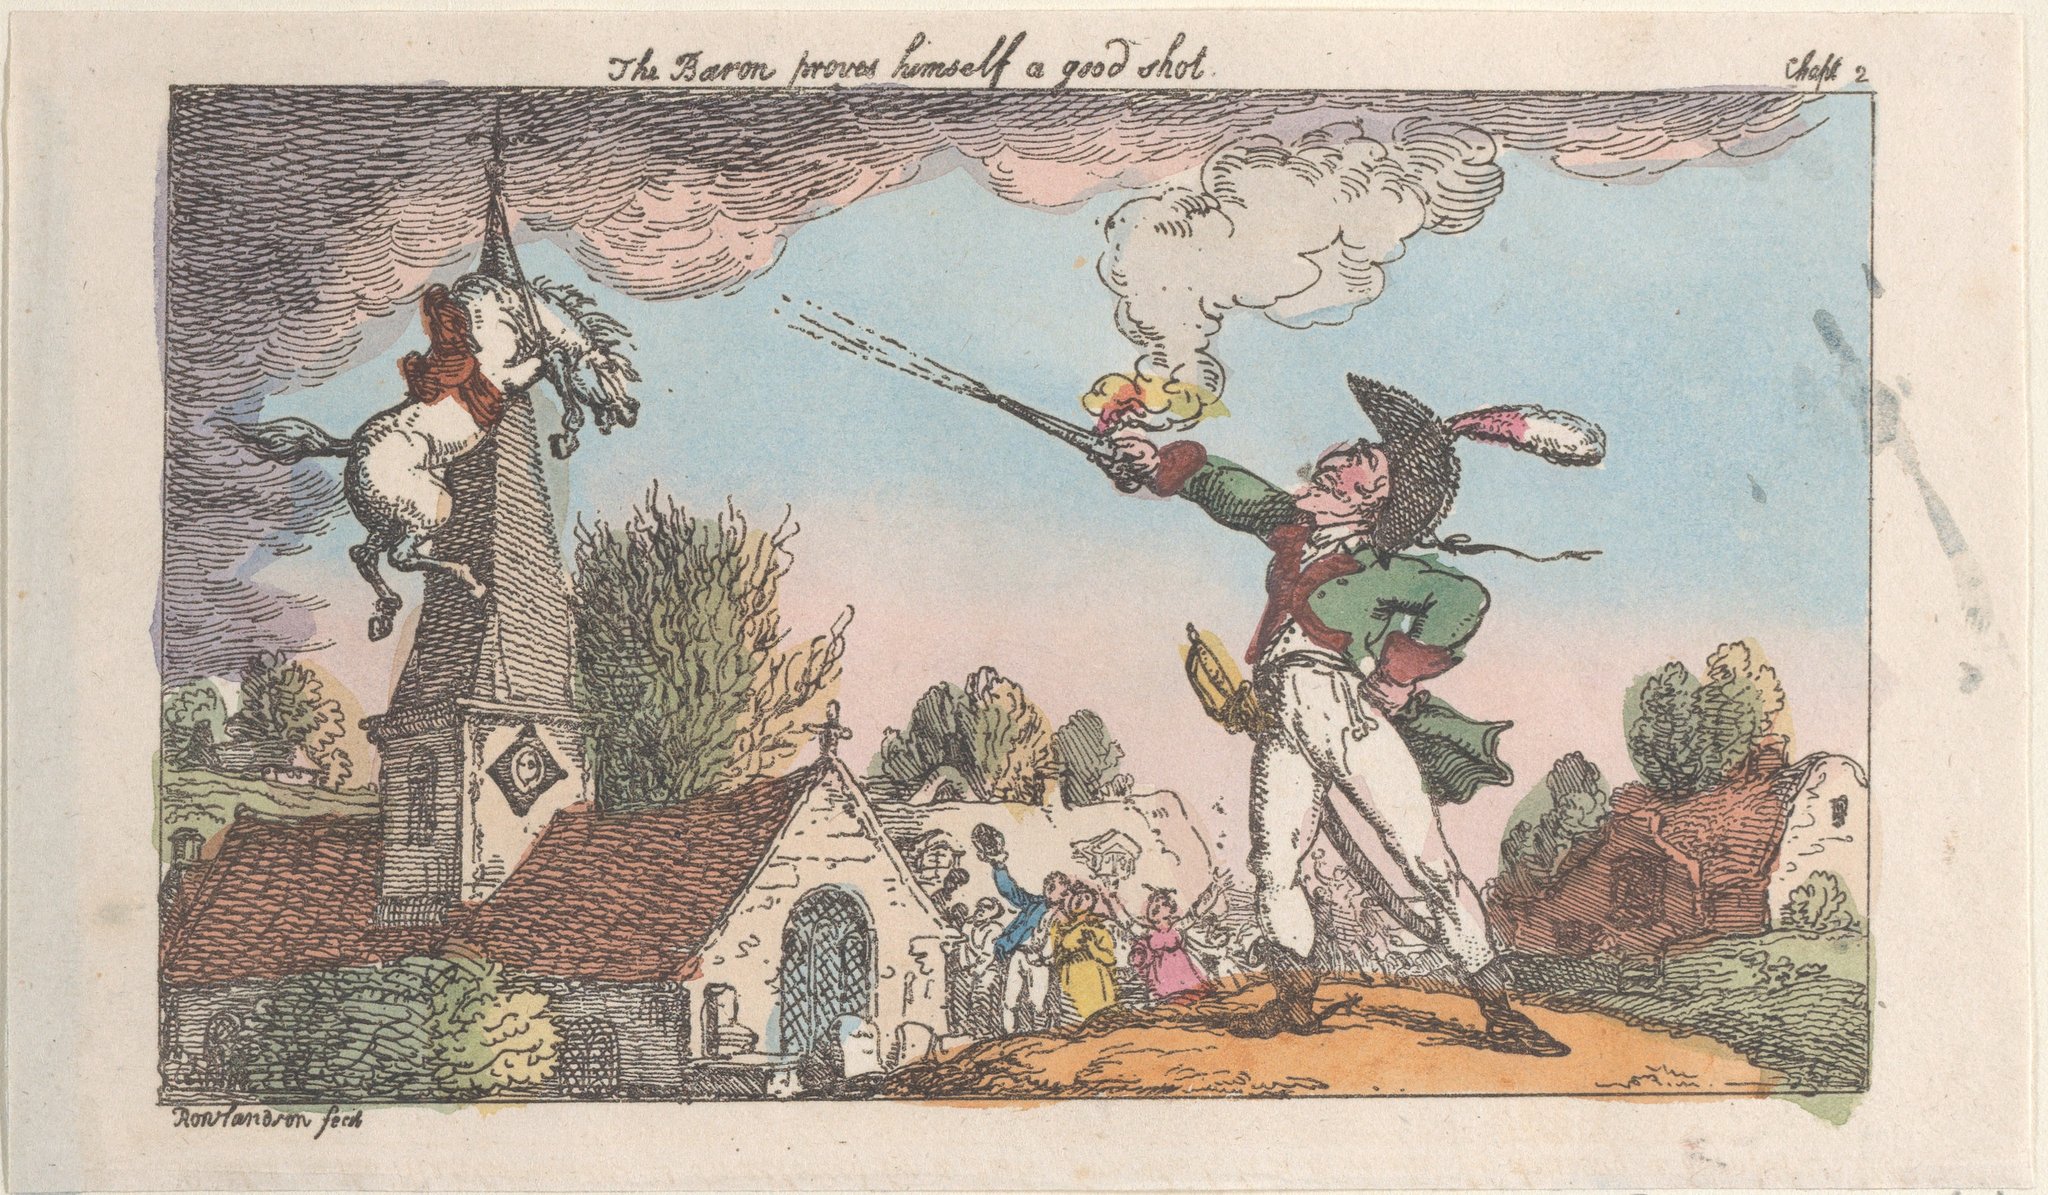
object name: print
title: The Baron proves himself a good shot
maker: thomas rowlandson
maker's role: artist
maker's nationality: british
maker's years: 1757-1827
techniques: etching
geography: london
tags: satire,men,horses